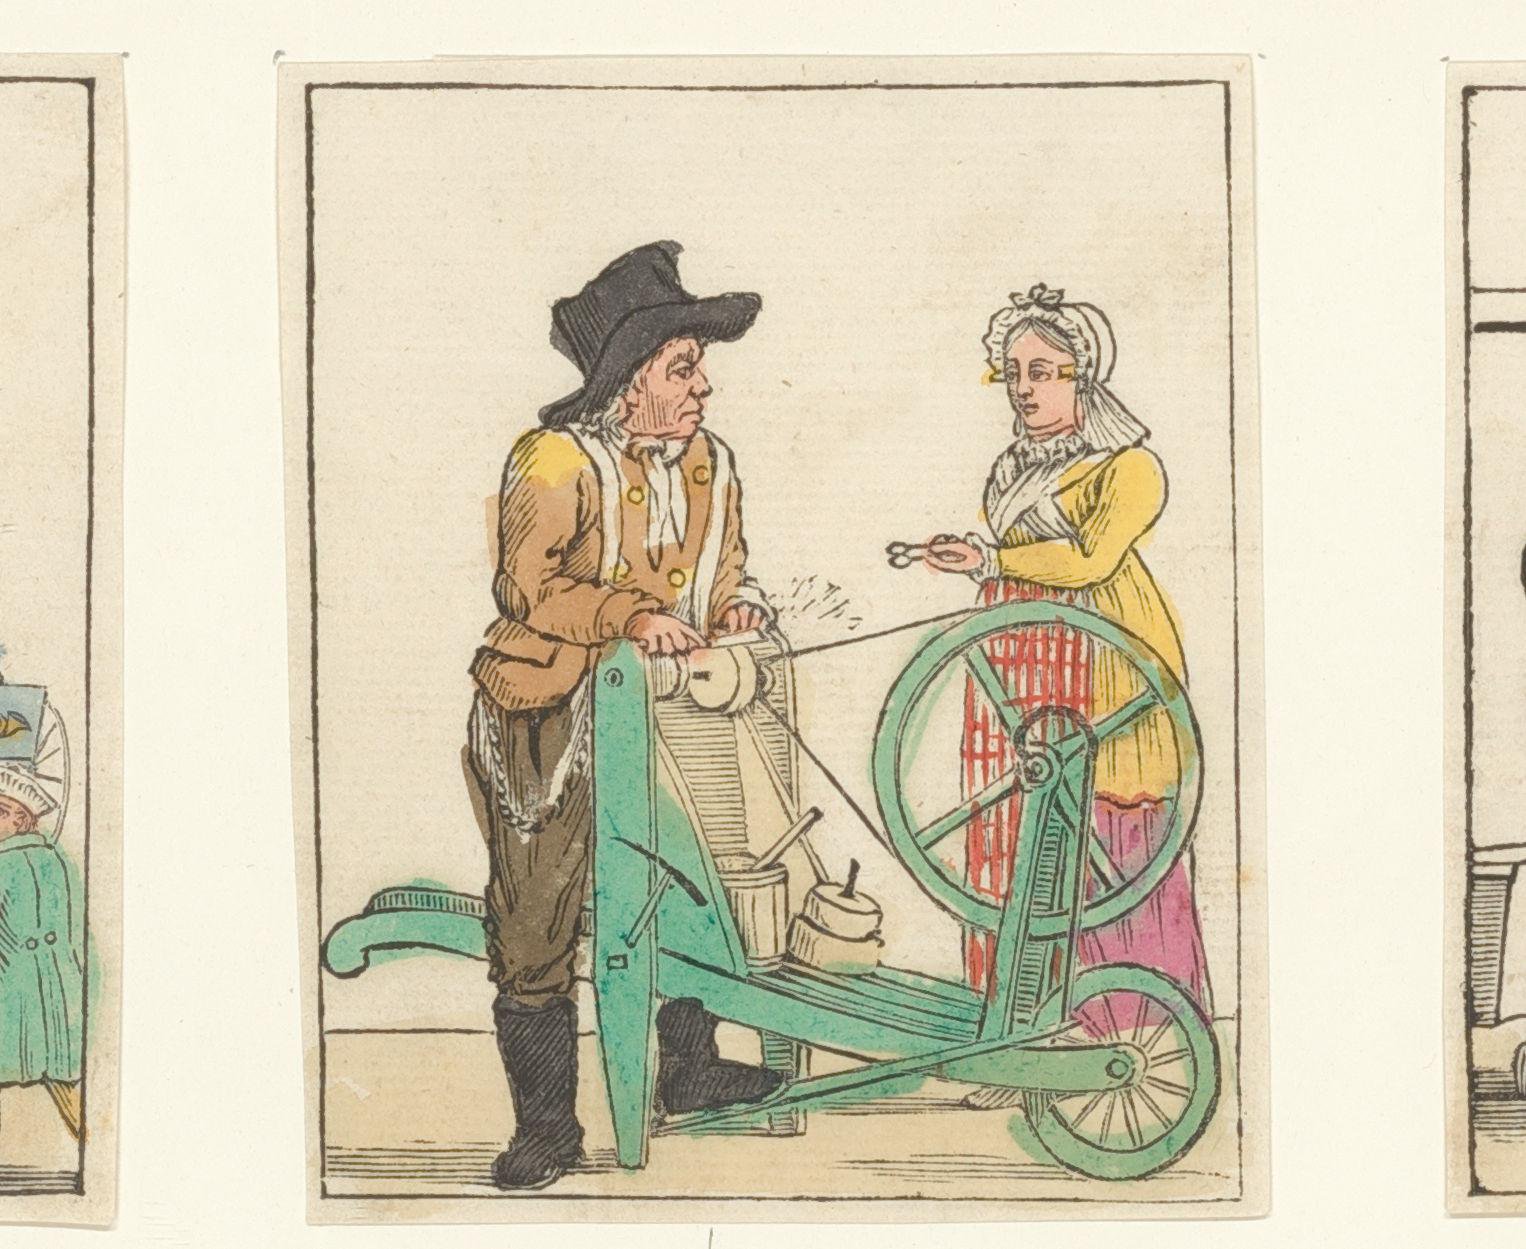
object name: book illustration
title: Scharenslijper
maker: Anonymous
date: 1827-1830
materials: paper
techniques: hand coloring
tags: handicrafts, craftsman at work, tools, aids, implements ~ crafts and industries: scissors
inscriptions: collector's mark: Lugt 1641, stamp, collector's mark: Lugt 1641a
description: Prent waarschijnlijk uit: Nuttige en vermakelijke prentverbeeldingen: met ophelderende gesprekken, kleine raadsels en charaden. Rotterdam: T.J. WIjnhoven Hendriksen, 1830. Of een eerdere uitgave (1827).